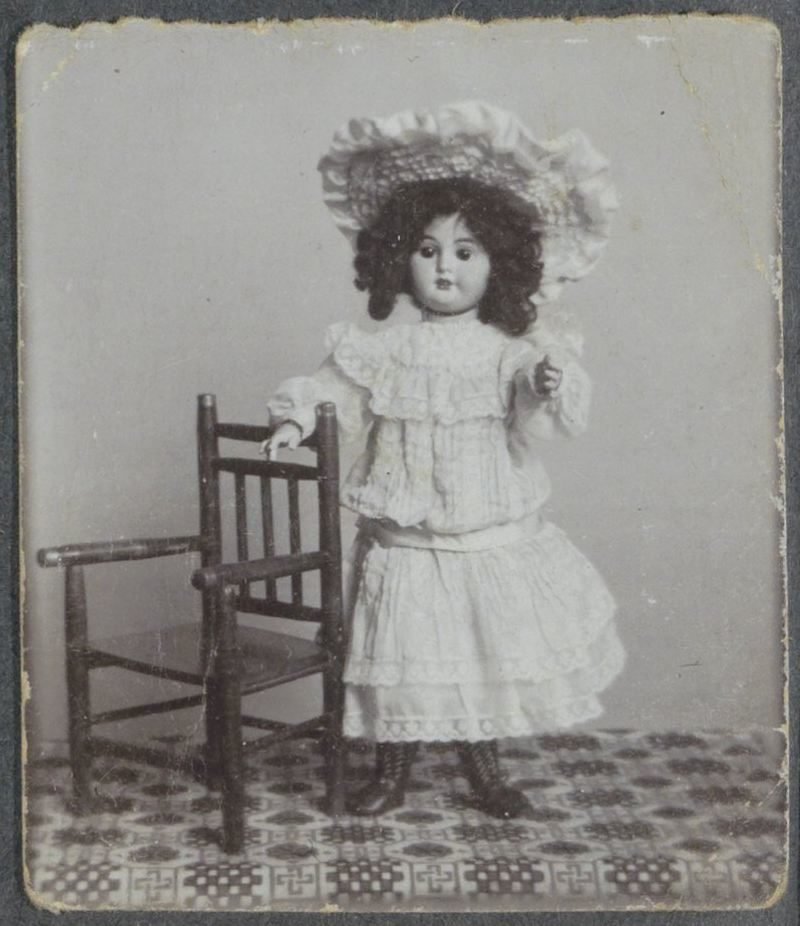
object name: album leaf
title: Portret van een pop met een miniatuurstoel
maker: Anonymous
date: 1920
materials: cardboard, paper, photographic support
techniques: collodion silver print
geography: netherlands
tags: studio requisites ~ photographer, doll's clothes, historical persons, (playing with) dolls, chair, netherlands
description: Onderdeel van Fotoalbum met portretten vervaardigd door Nederlandse studio's waaronder automaatfoto's.